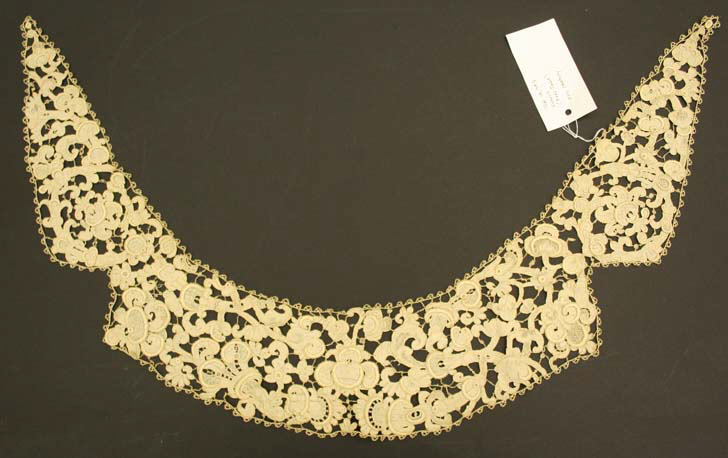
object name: collar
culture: french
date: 1601-1700